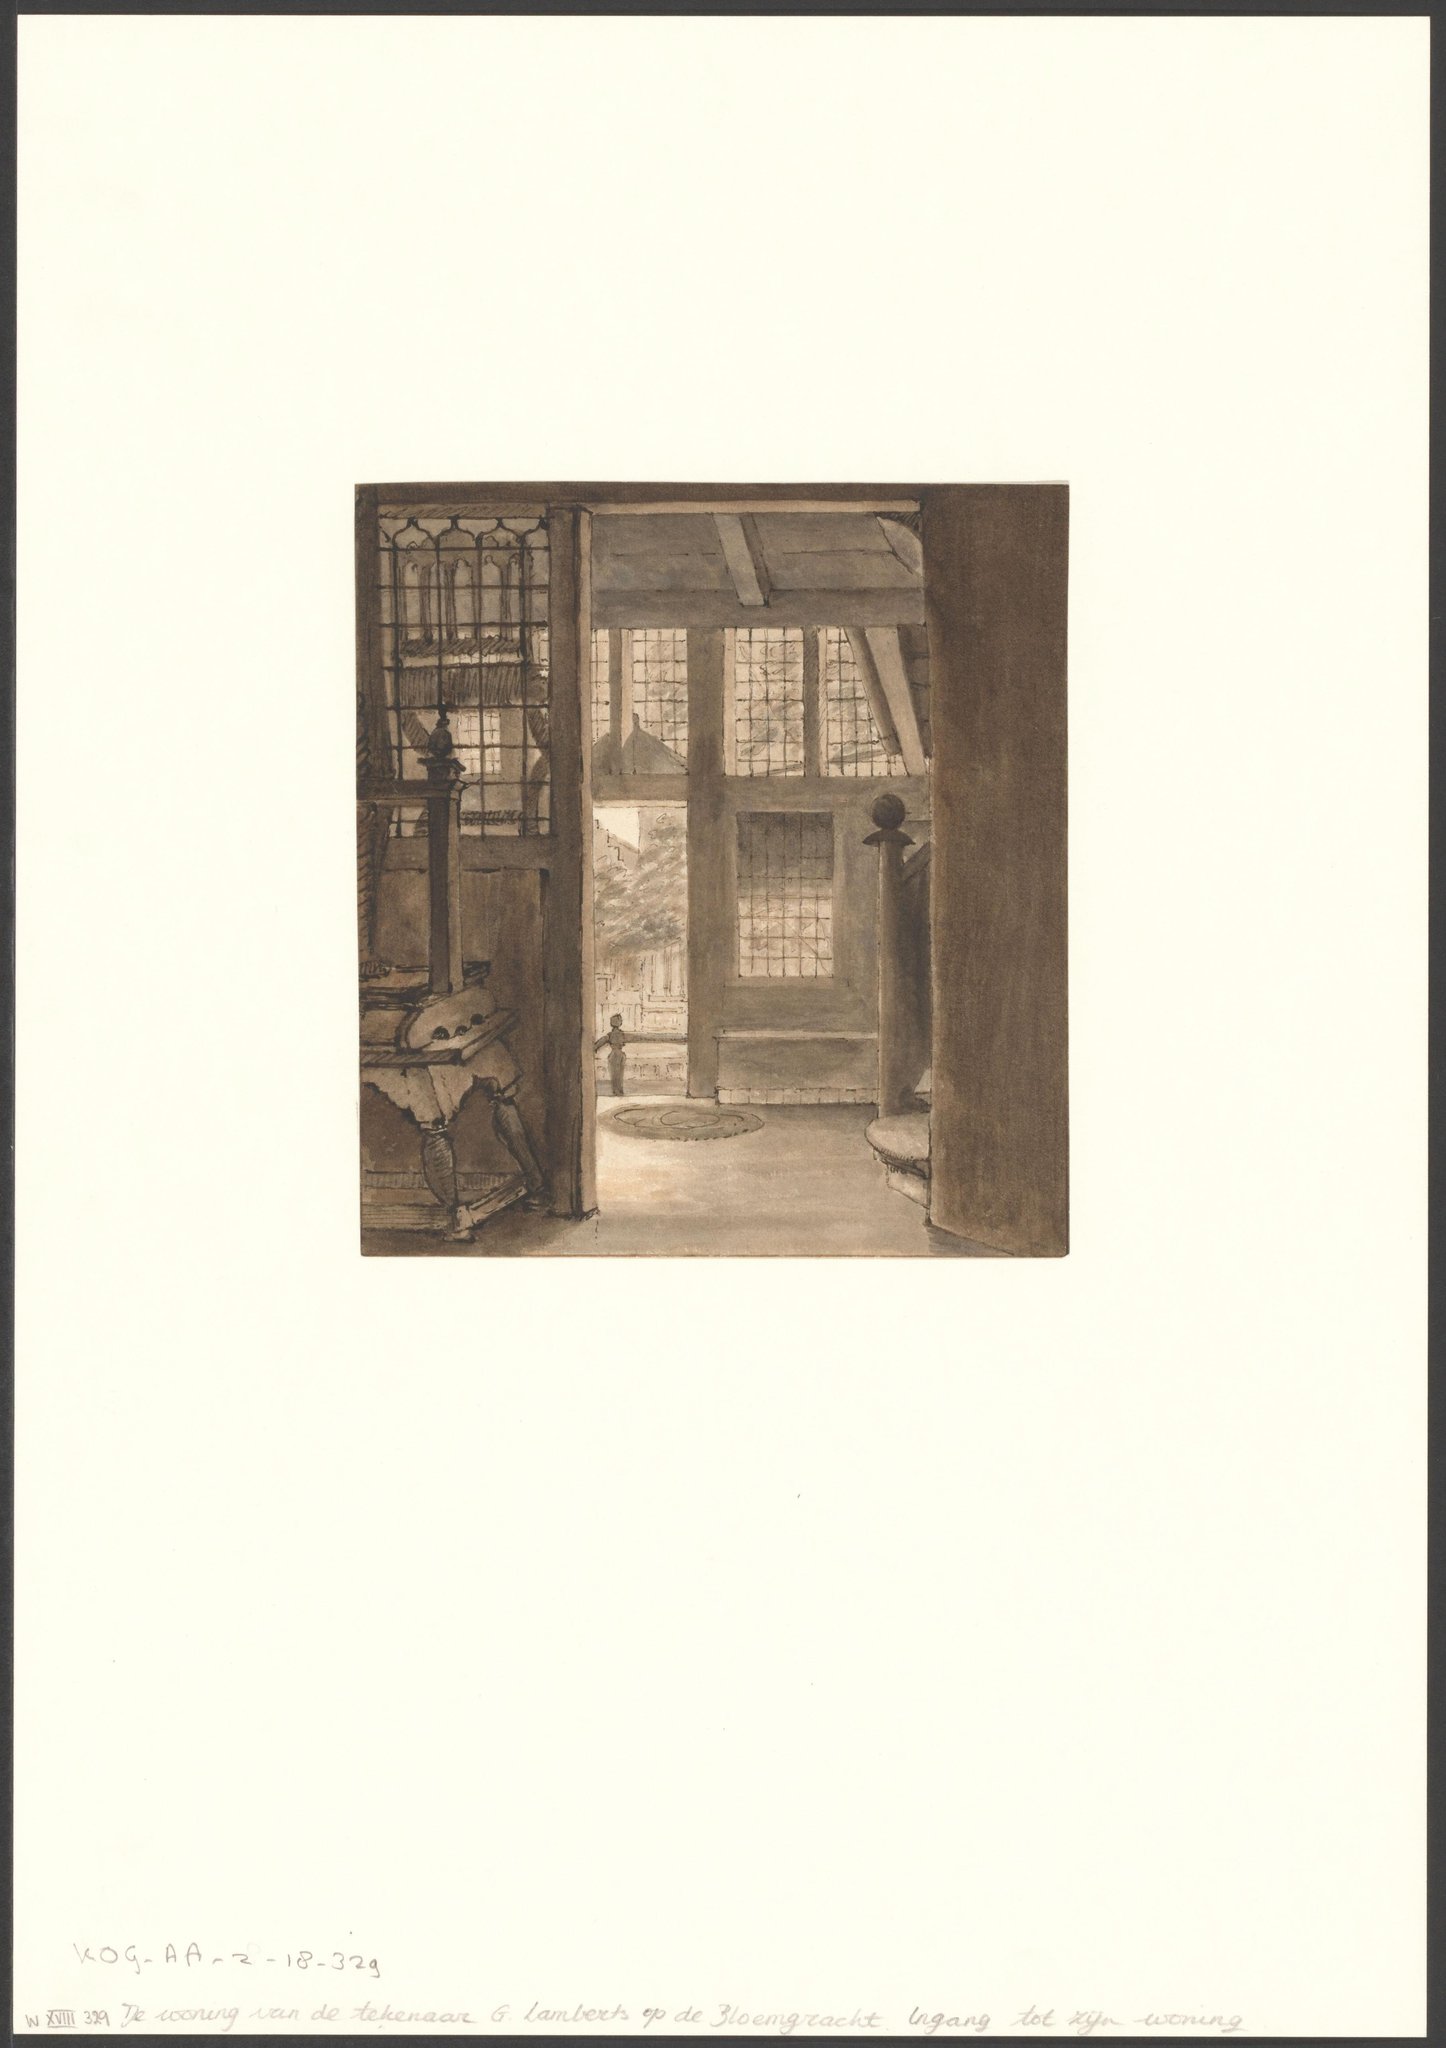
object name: drawing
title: Ingang tot de woning van de kunstenaar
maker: gerrit lamberts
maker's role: bookseller, draughtsman, print maker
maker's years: 1776-1850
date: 1786-1850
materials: ink, paper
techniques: brush, pen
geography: amsterdam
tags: gate, entrance, door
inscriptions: collector's mark: Lugt 800a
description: Tekening binnen de Atlas Van Eck ingedeeld op wijknummer 18.